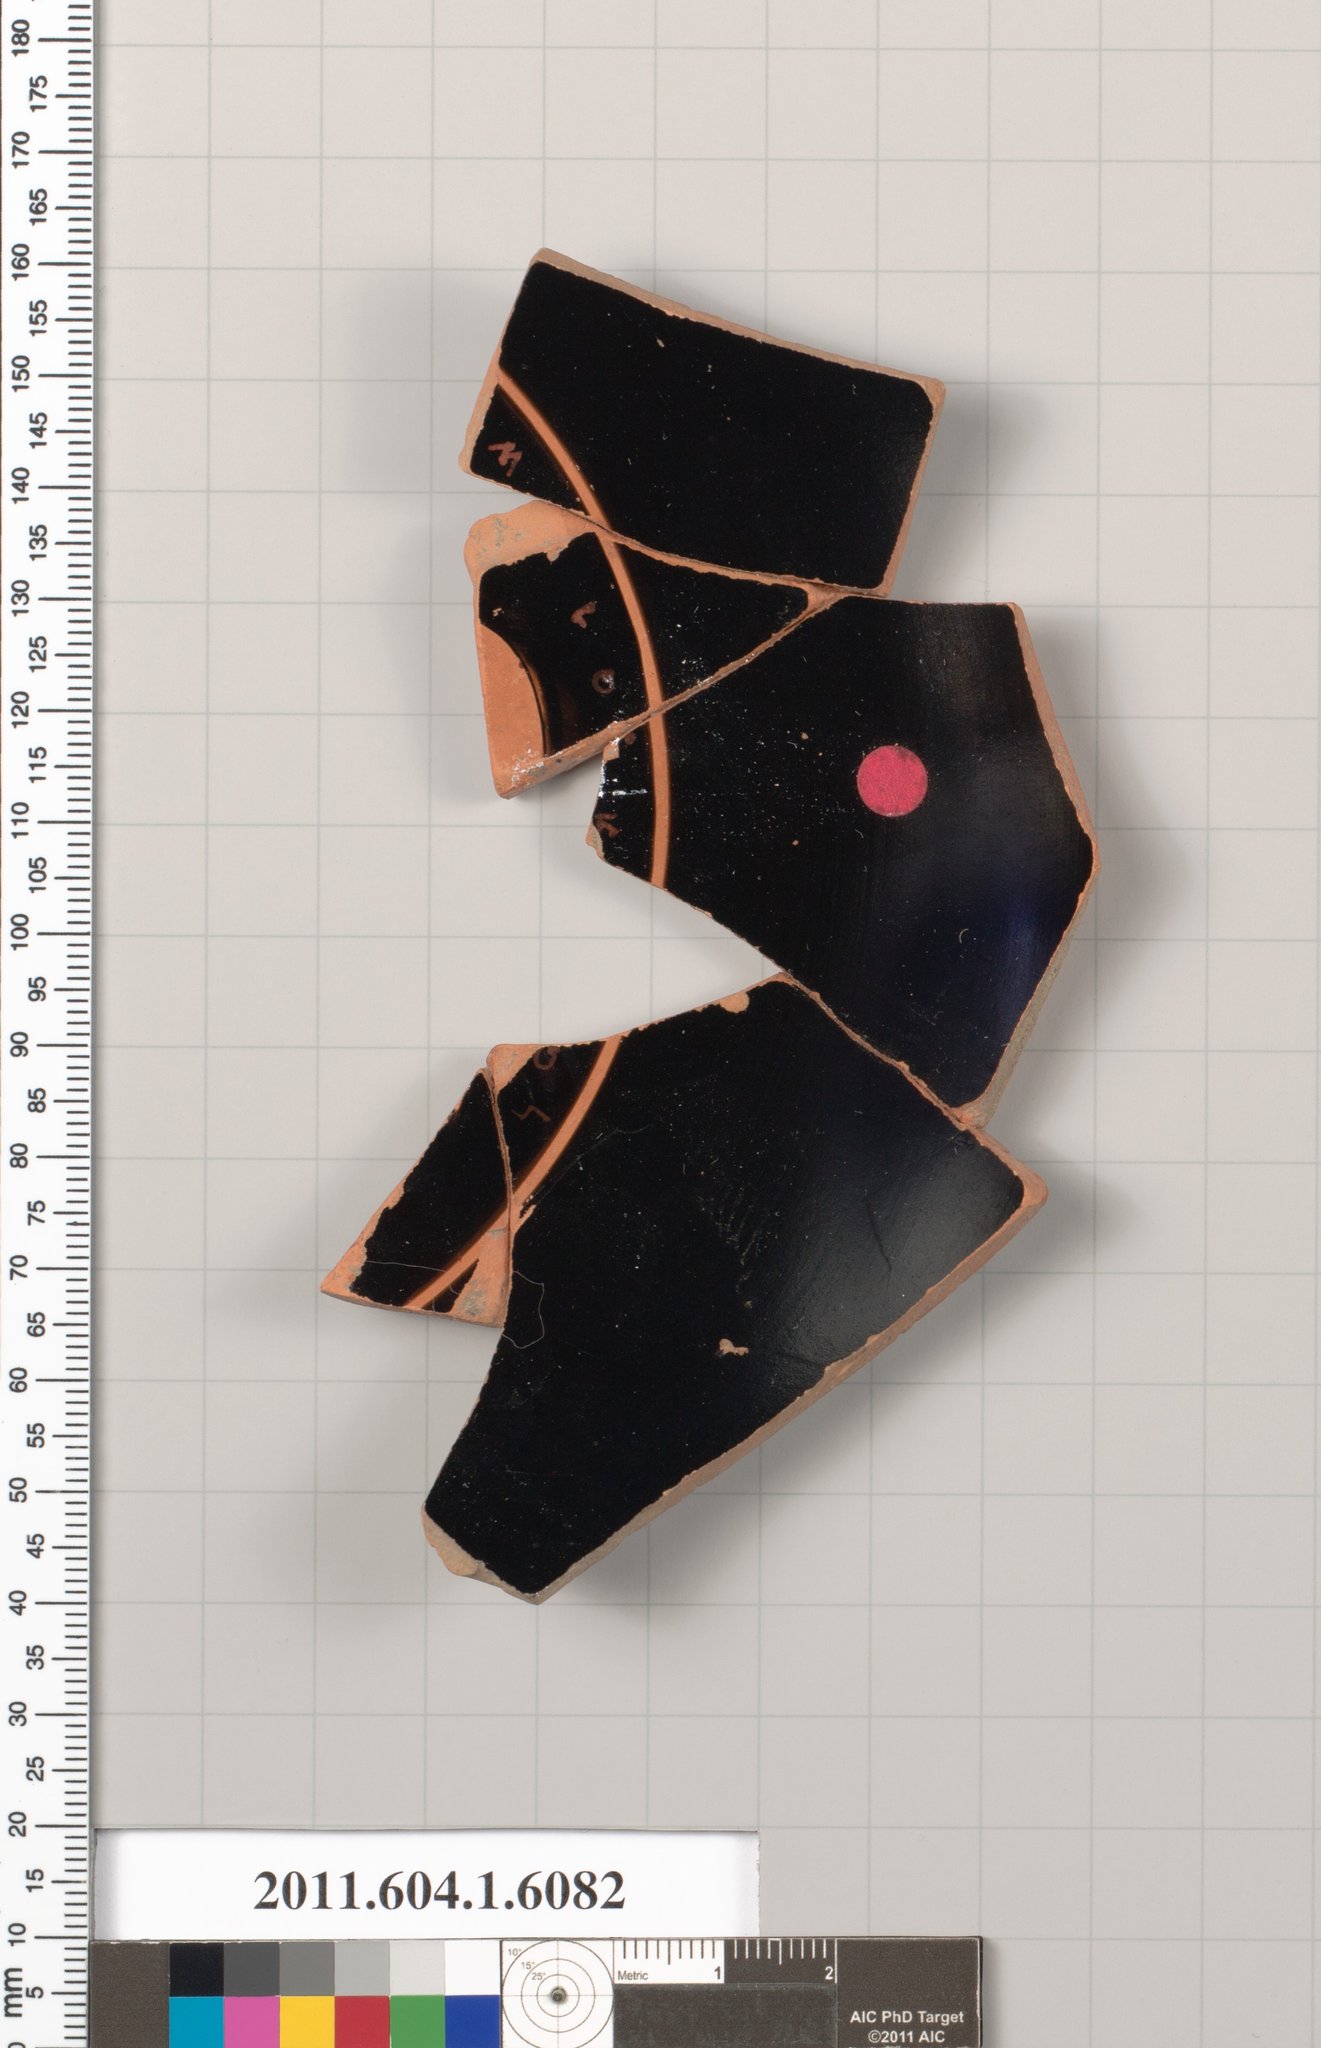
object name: kylix fragment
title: Terracotta fragment of a kylix (drinking cup)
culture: greek, attic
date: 500-490 BCE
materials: terracotta